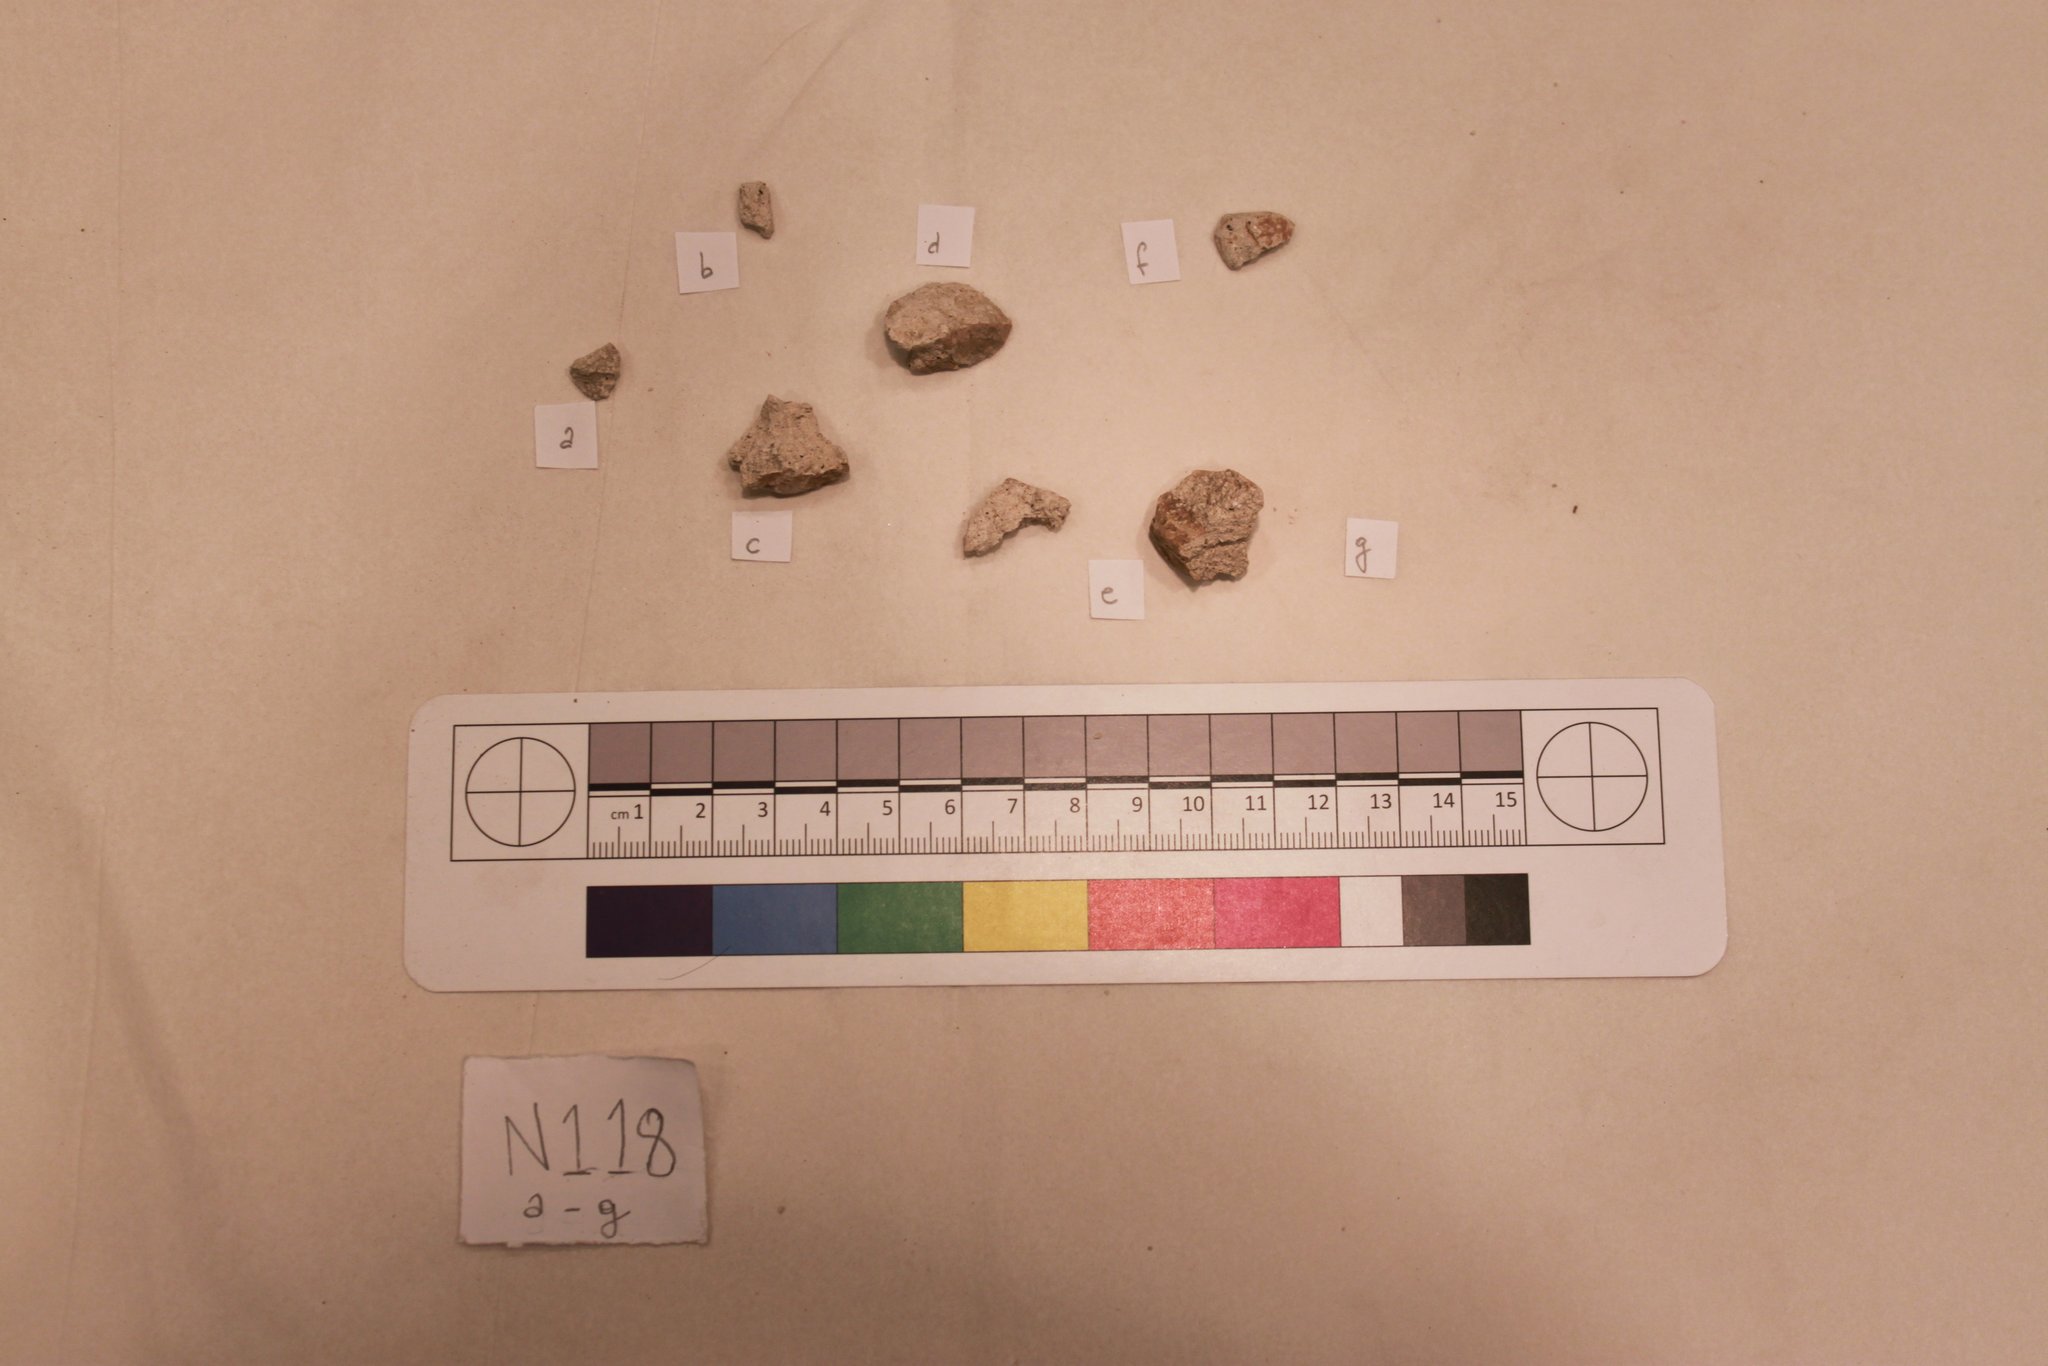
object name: fragment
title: Stucco Fragment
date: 701-1200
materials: plaster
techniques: carving, painting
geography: iran